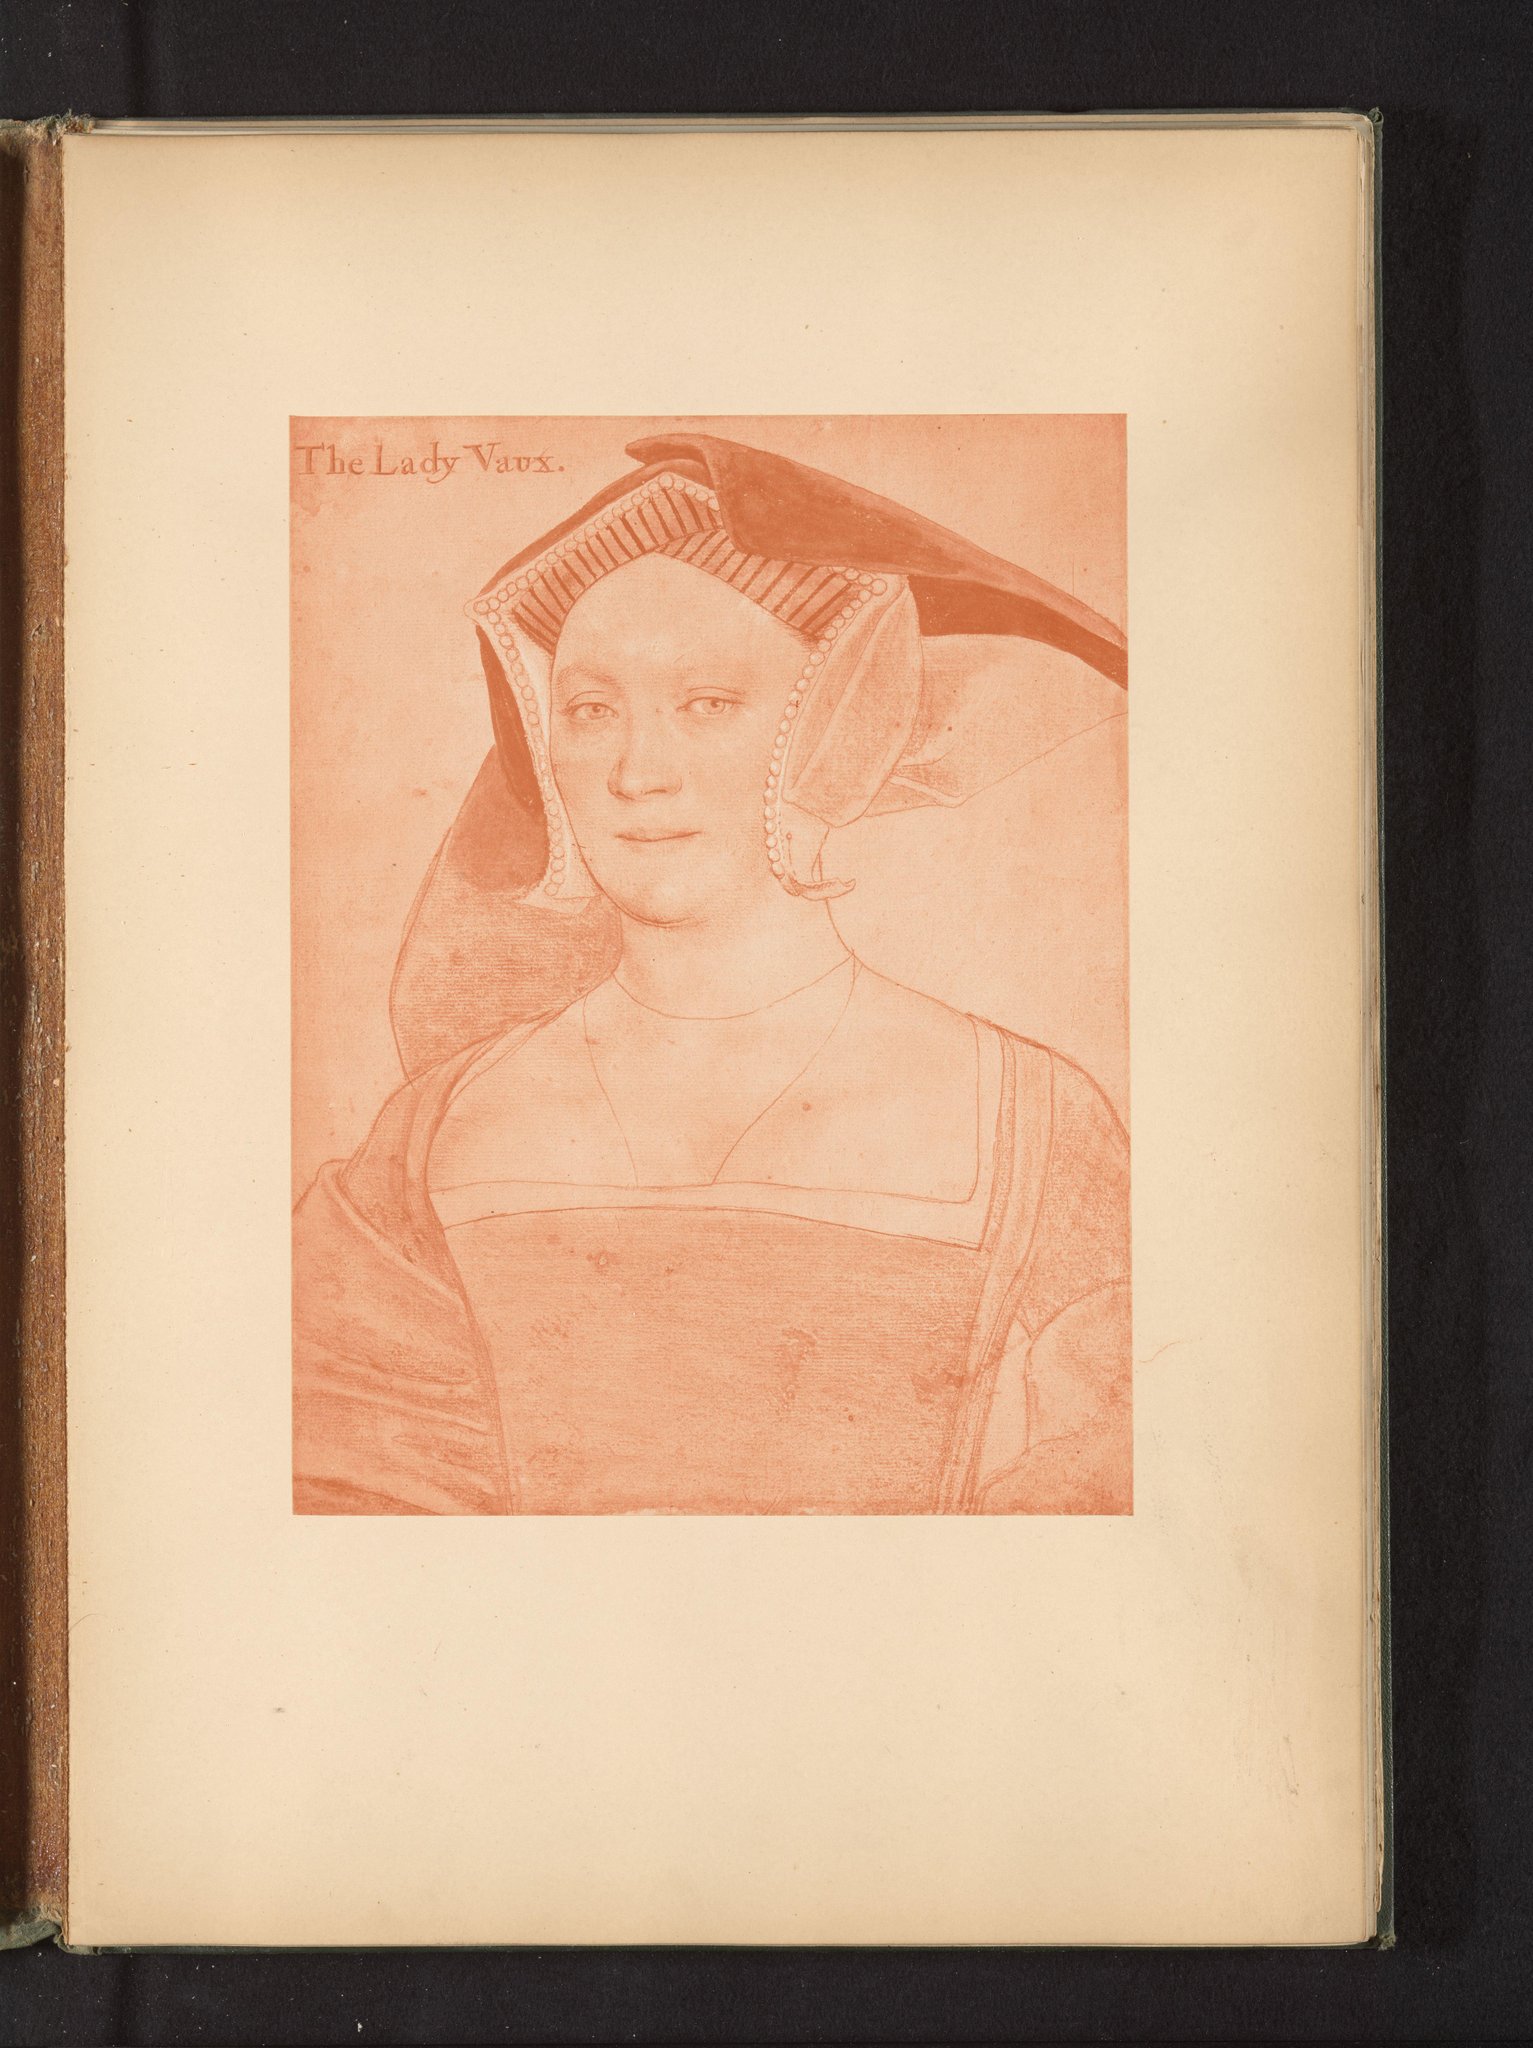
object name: page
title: Fotoreproductie van een portret van Elizabeth Vaux door Hans Holbein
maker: Anonymous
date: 1872-1877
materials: paper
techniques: carbon print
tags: drawing, sketch, historical persons - bb - woman